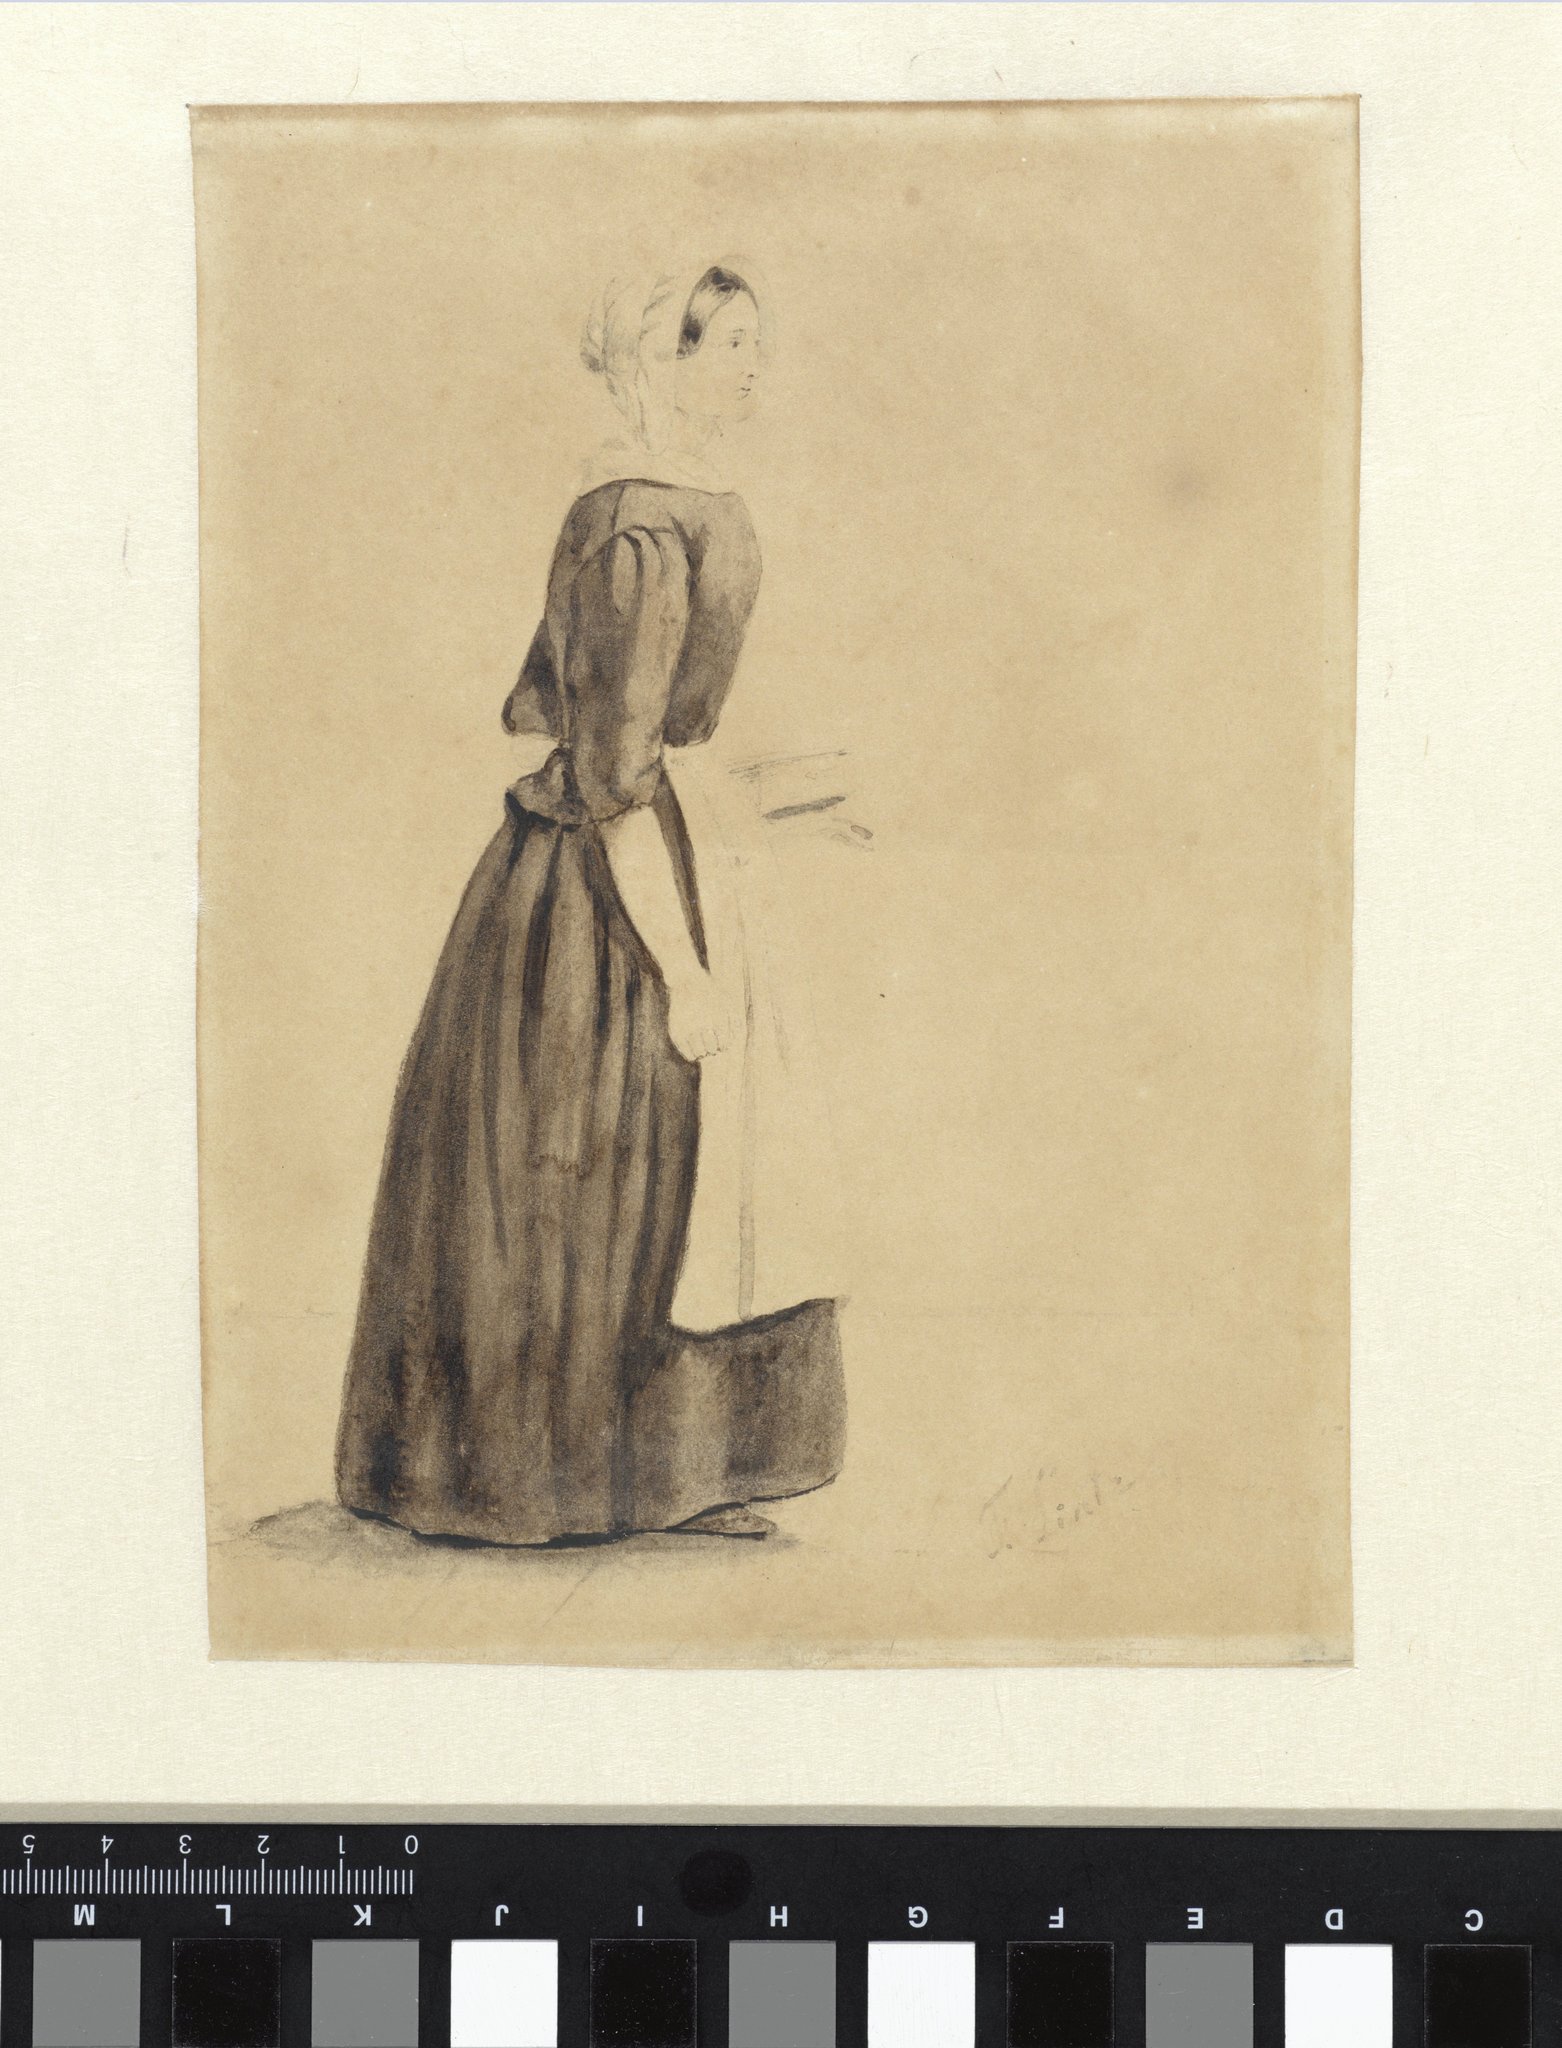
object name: drawing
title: Staande vrouw, in profiel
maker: ferdinand ernst lintz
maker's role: draughtsman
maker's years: 1833-1909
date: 1843-1909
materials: paper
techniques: brush